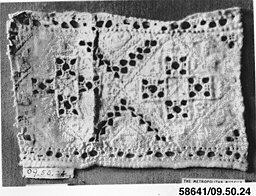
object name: fragment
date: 1801-1900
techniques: embroidery